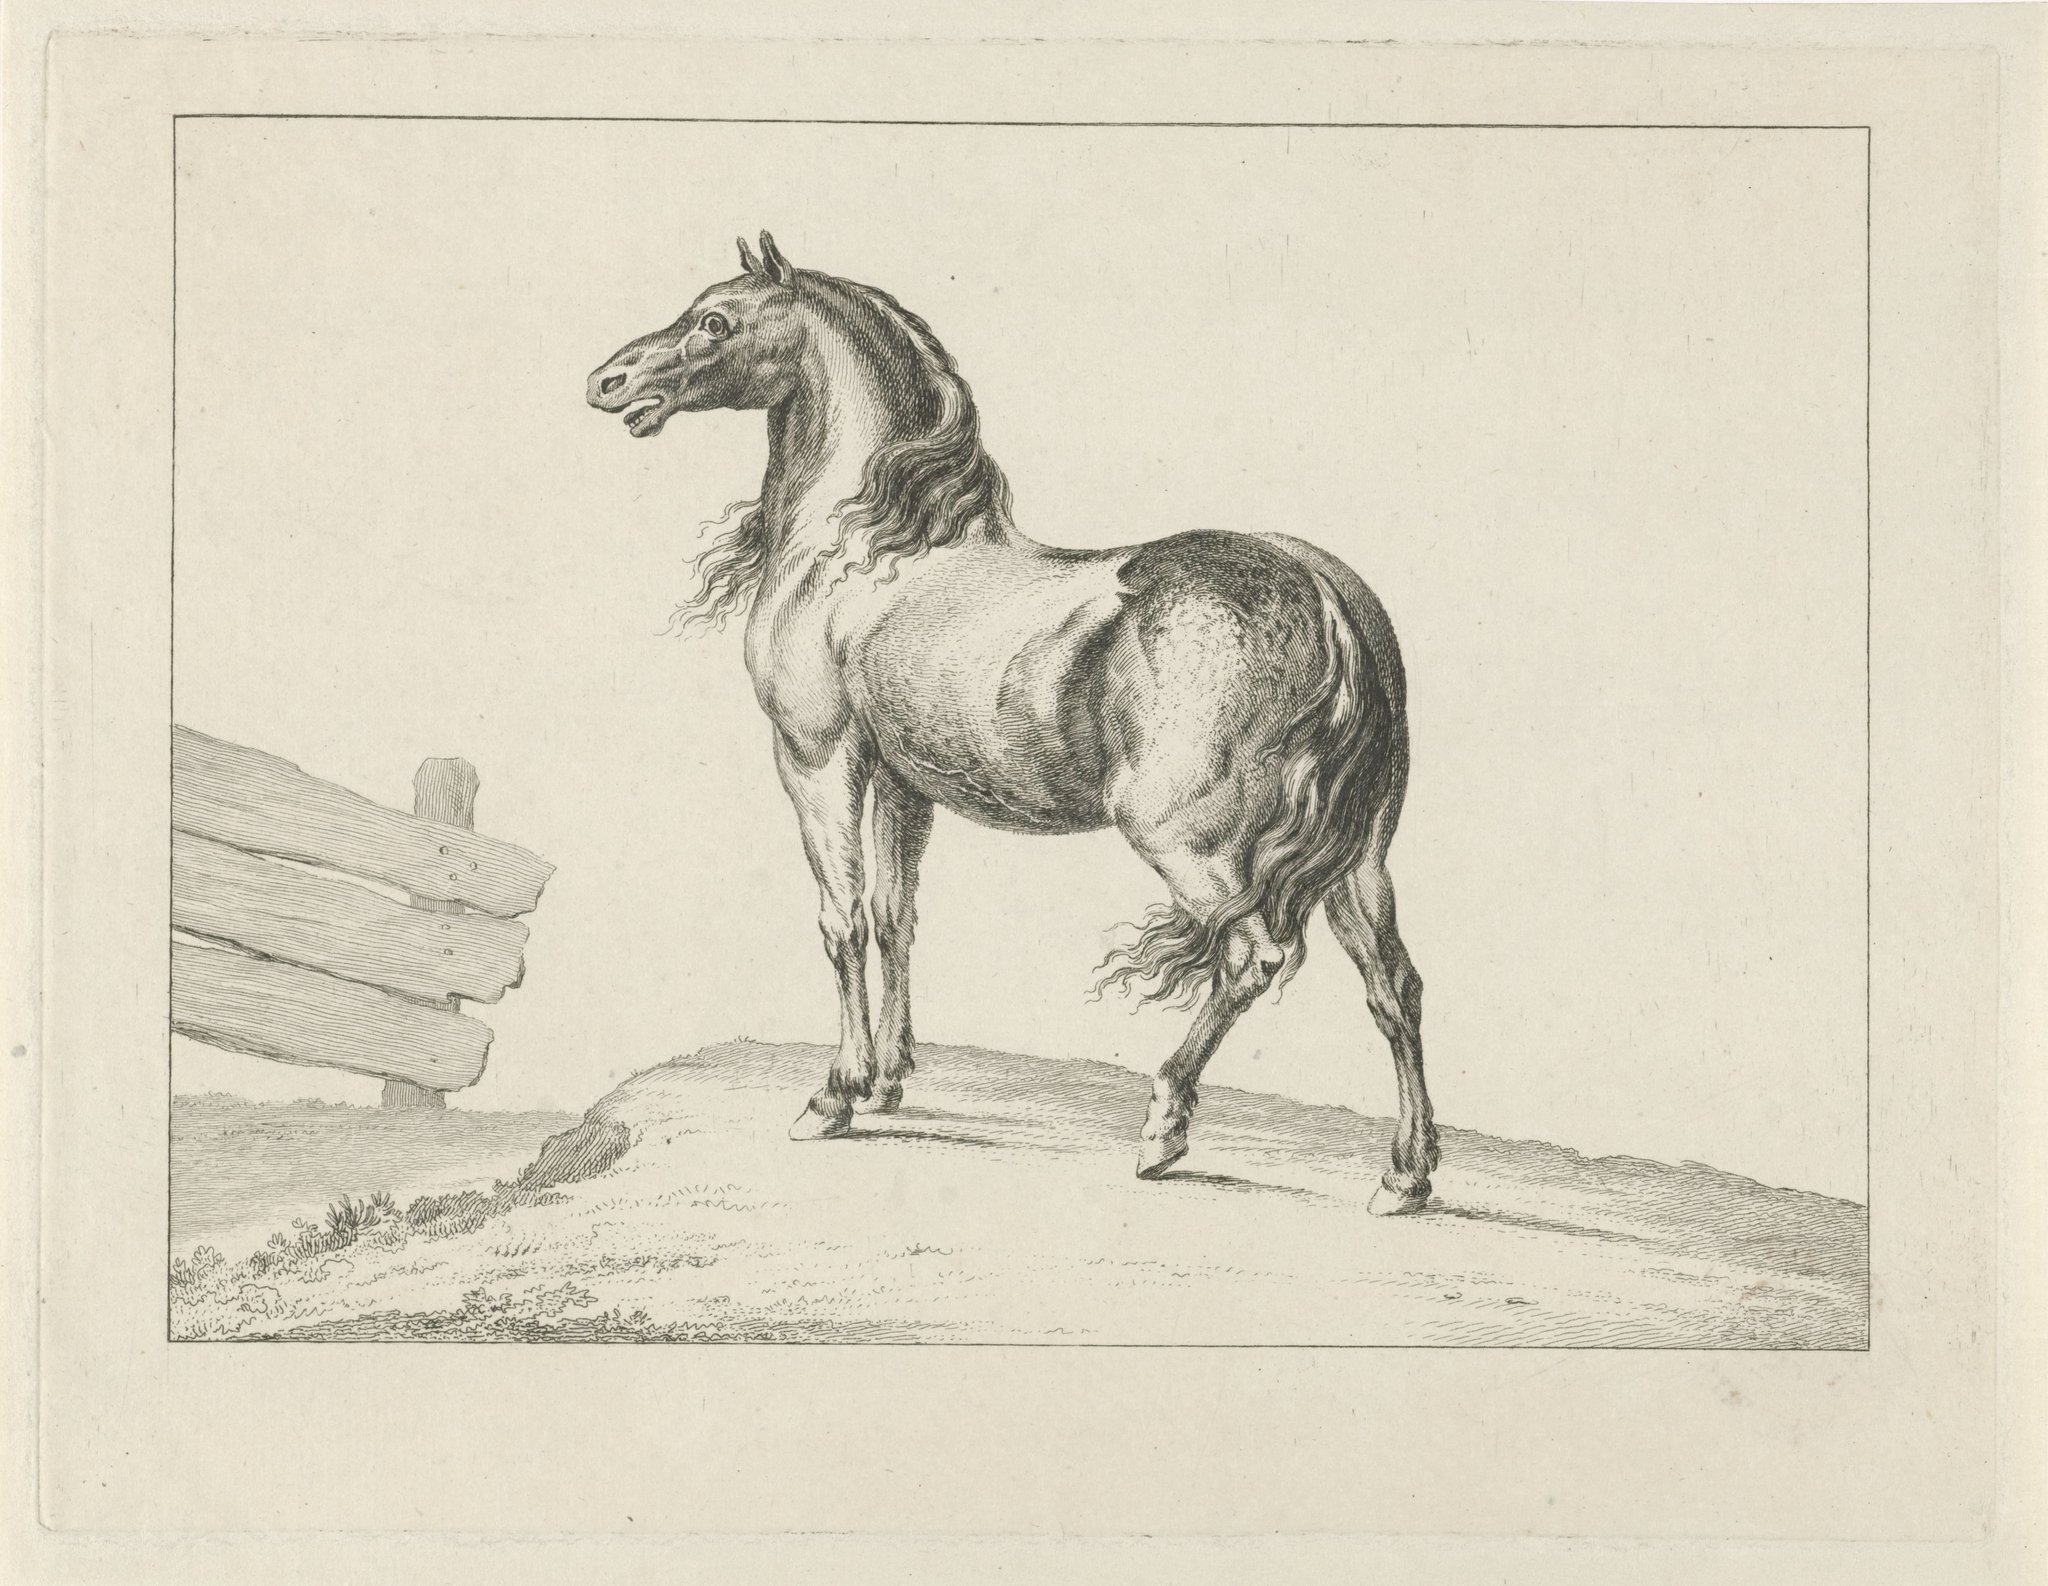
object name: print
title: Paard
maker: pieter de mare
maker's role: print maker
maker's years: 1758-1796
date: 1768-1796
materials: paper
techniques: etching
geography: leiden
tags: horse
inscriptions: collector's mark: Lugt 240